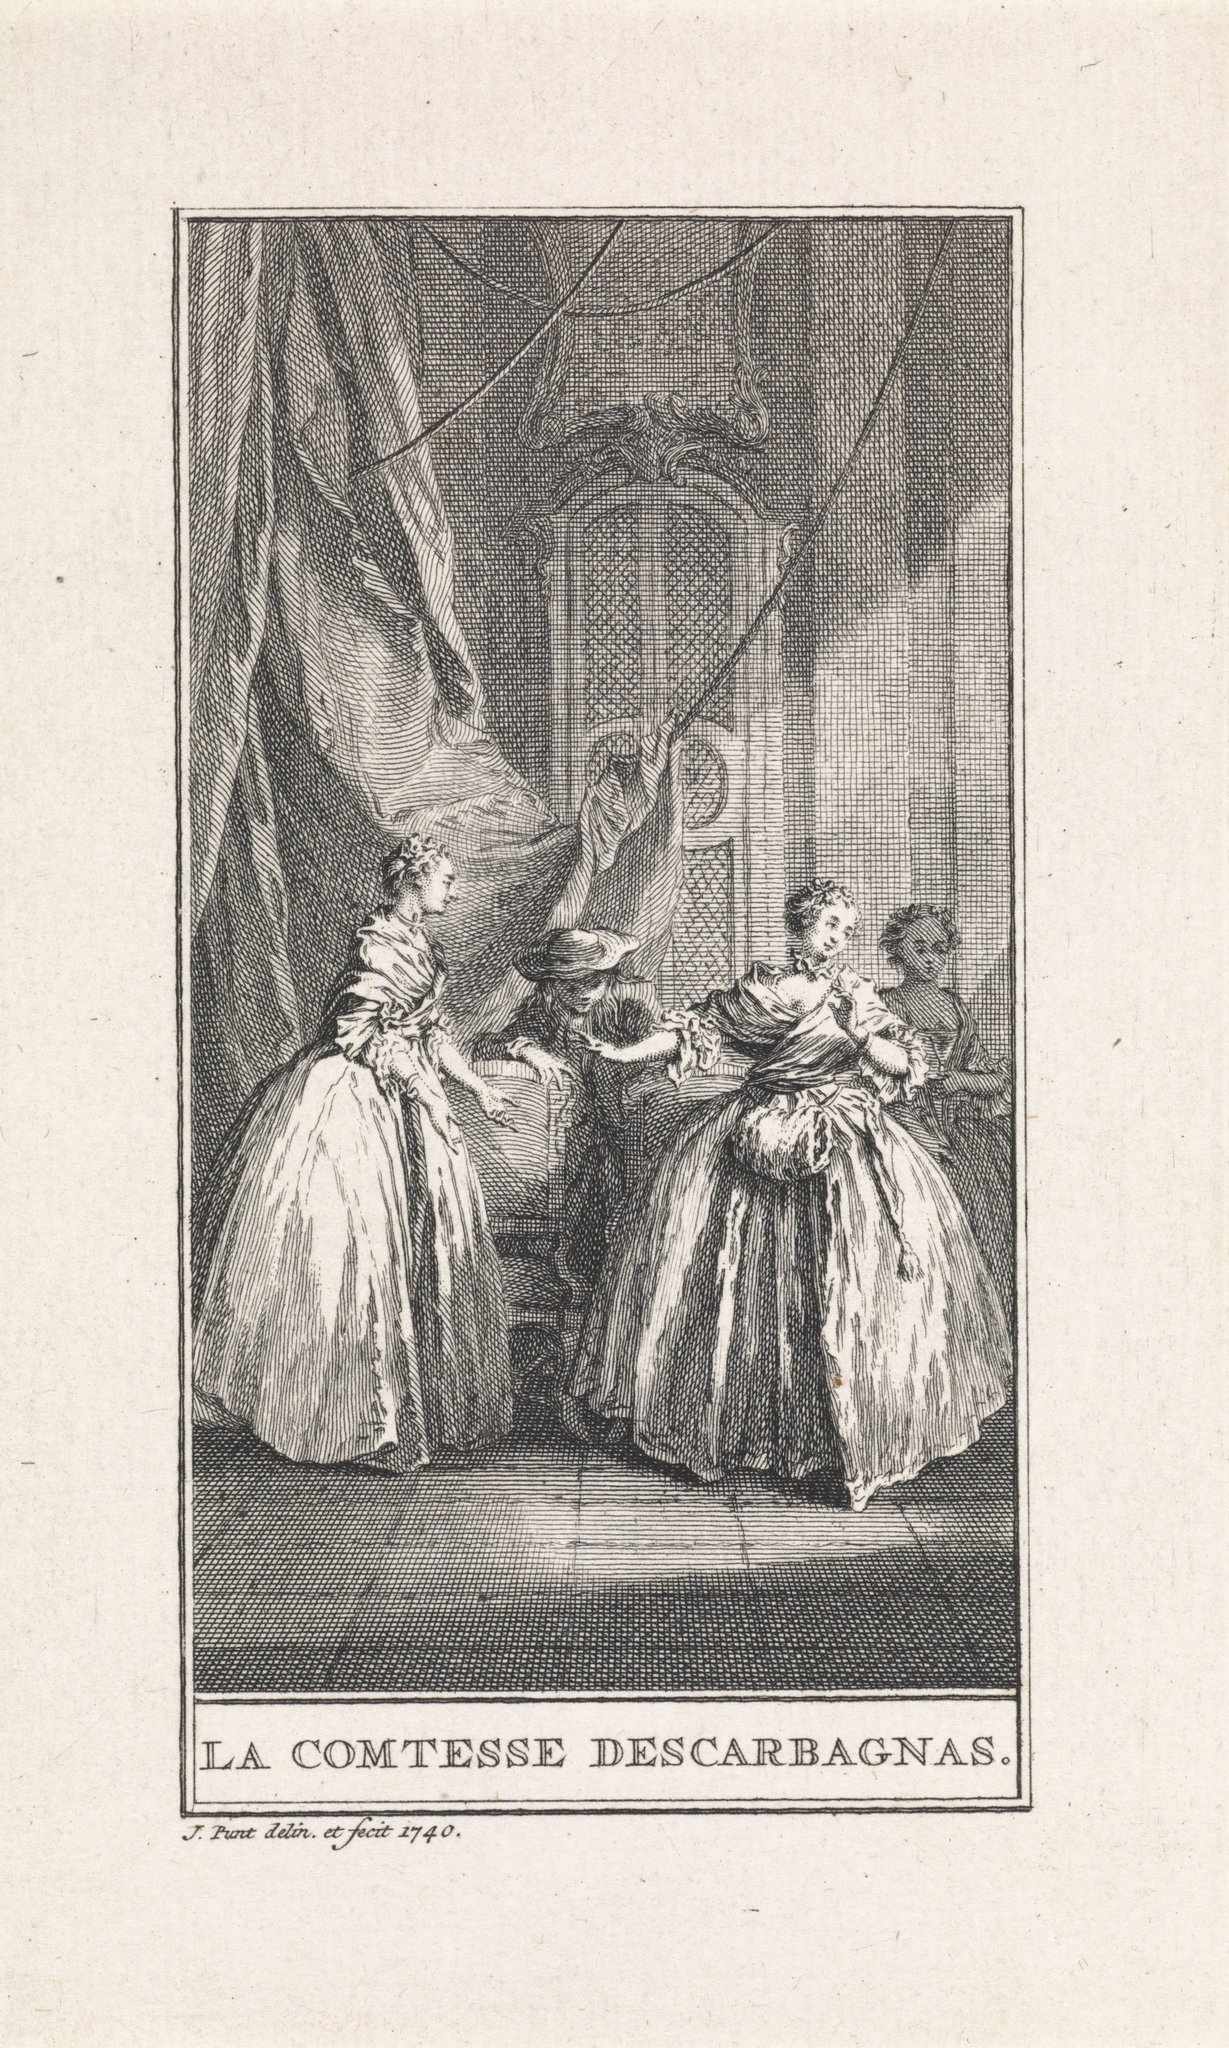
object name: book illustration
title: La Comtesse Descarbagnas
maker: jan punt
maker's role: draughtsman, print maker, publisher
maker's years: 1711-1779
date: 1740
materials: paper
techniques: engraving, etching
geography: amsterdam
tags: dress, gown: robe volante (+ women's clothes), fashionable woman, 'belle'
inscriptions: collector's mark: Lugt 2228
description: Twee hofdames zijn in gesprek. Een jonge man knielt voor hen. Op de achtergrond brengt een vrouw een glas. Scène uit het toneelstuk La Comtesse d'Escarbagnas (Het huwelijk van Gravin van Escarbagnas), van Molière.